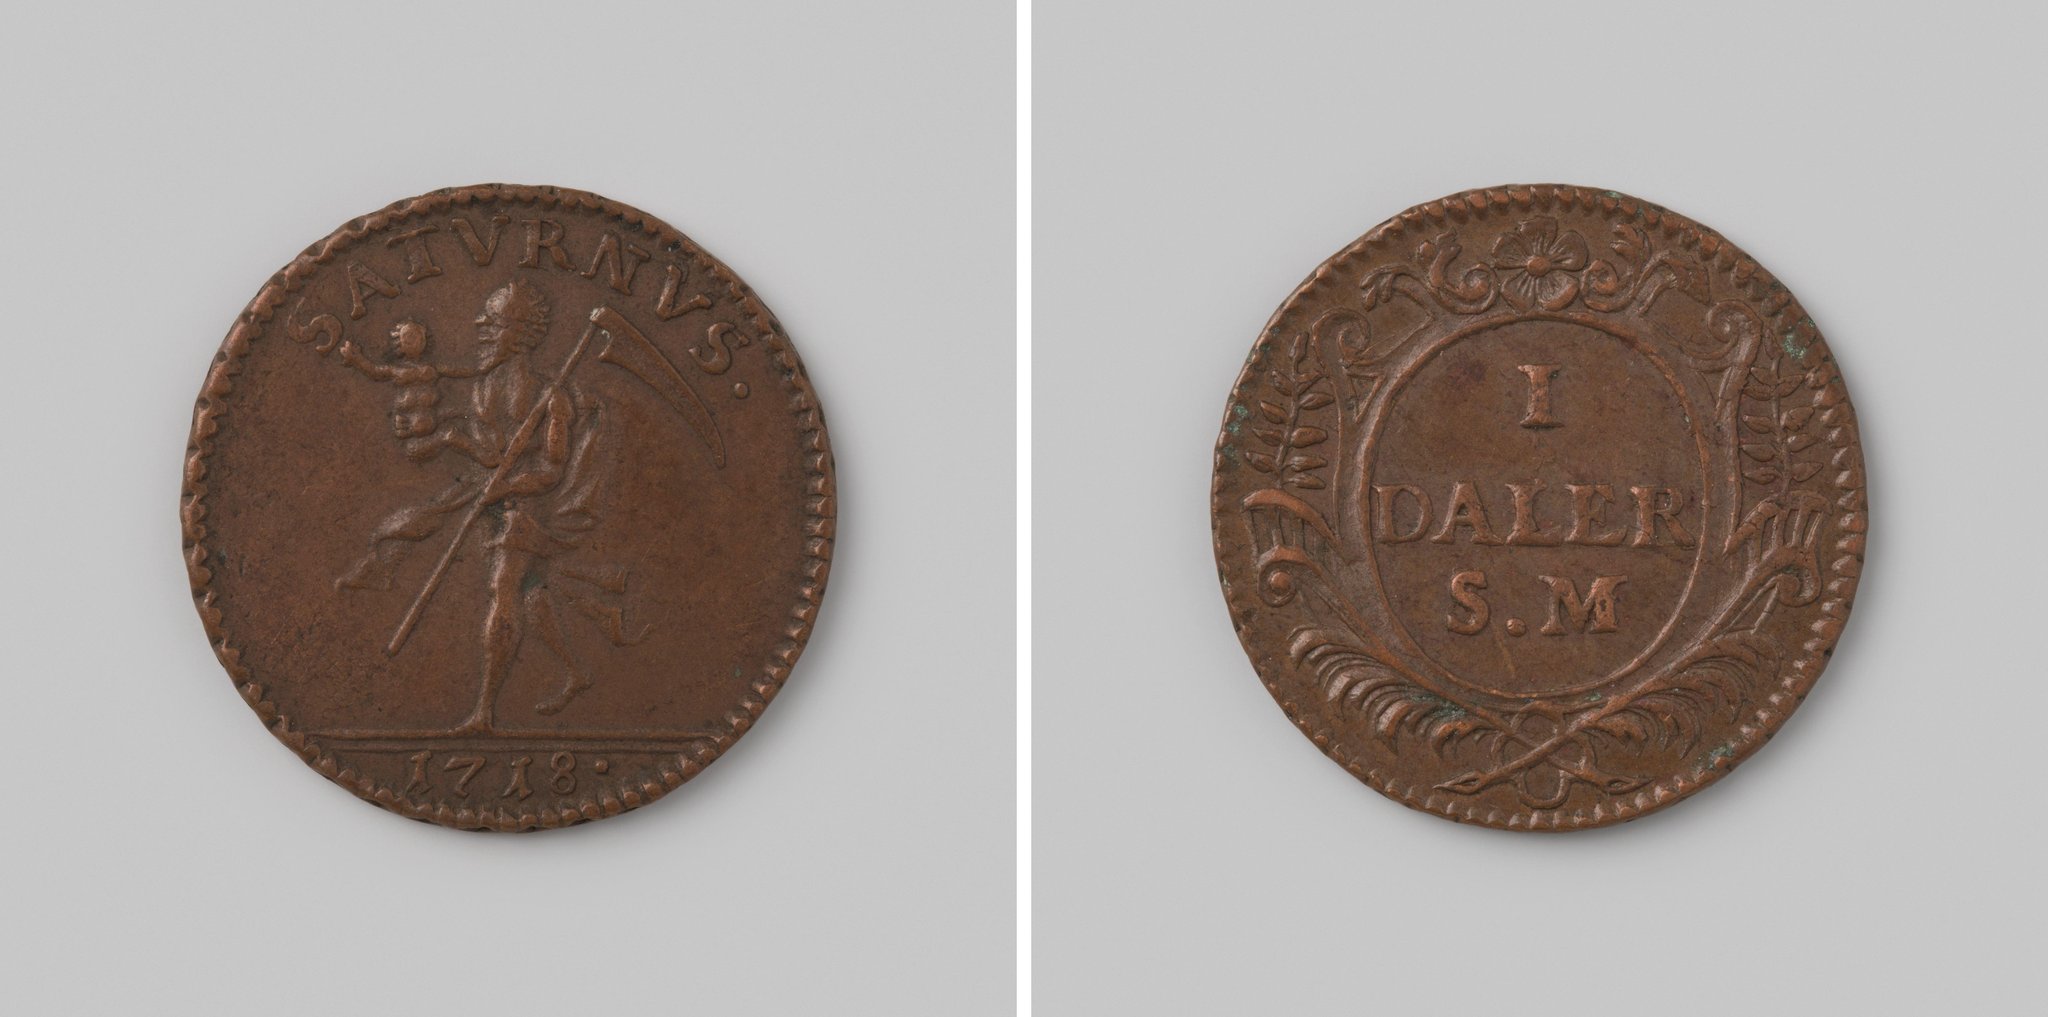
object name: siege coin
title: Zweden, Karel XII, daler S[ilver] M[ynt],1718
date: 1718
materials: copper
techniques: striking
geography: slot rörstrand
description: Koperen noodmunt. Voorzijde: lopende man naar links, in rechterhand kind, in linker zeis.Daarboven omschrift: saturnus. In afsnede jaartal. Keerzijde: binnen versierd rond wapenschild in drie regels waarde-aanduiding. Kabelrand.